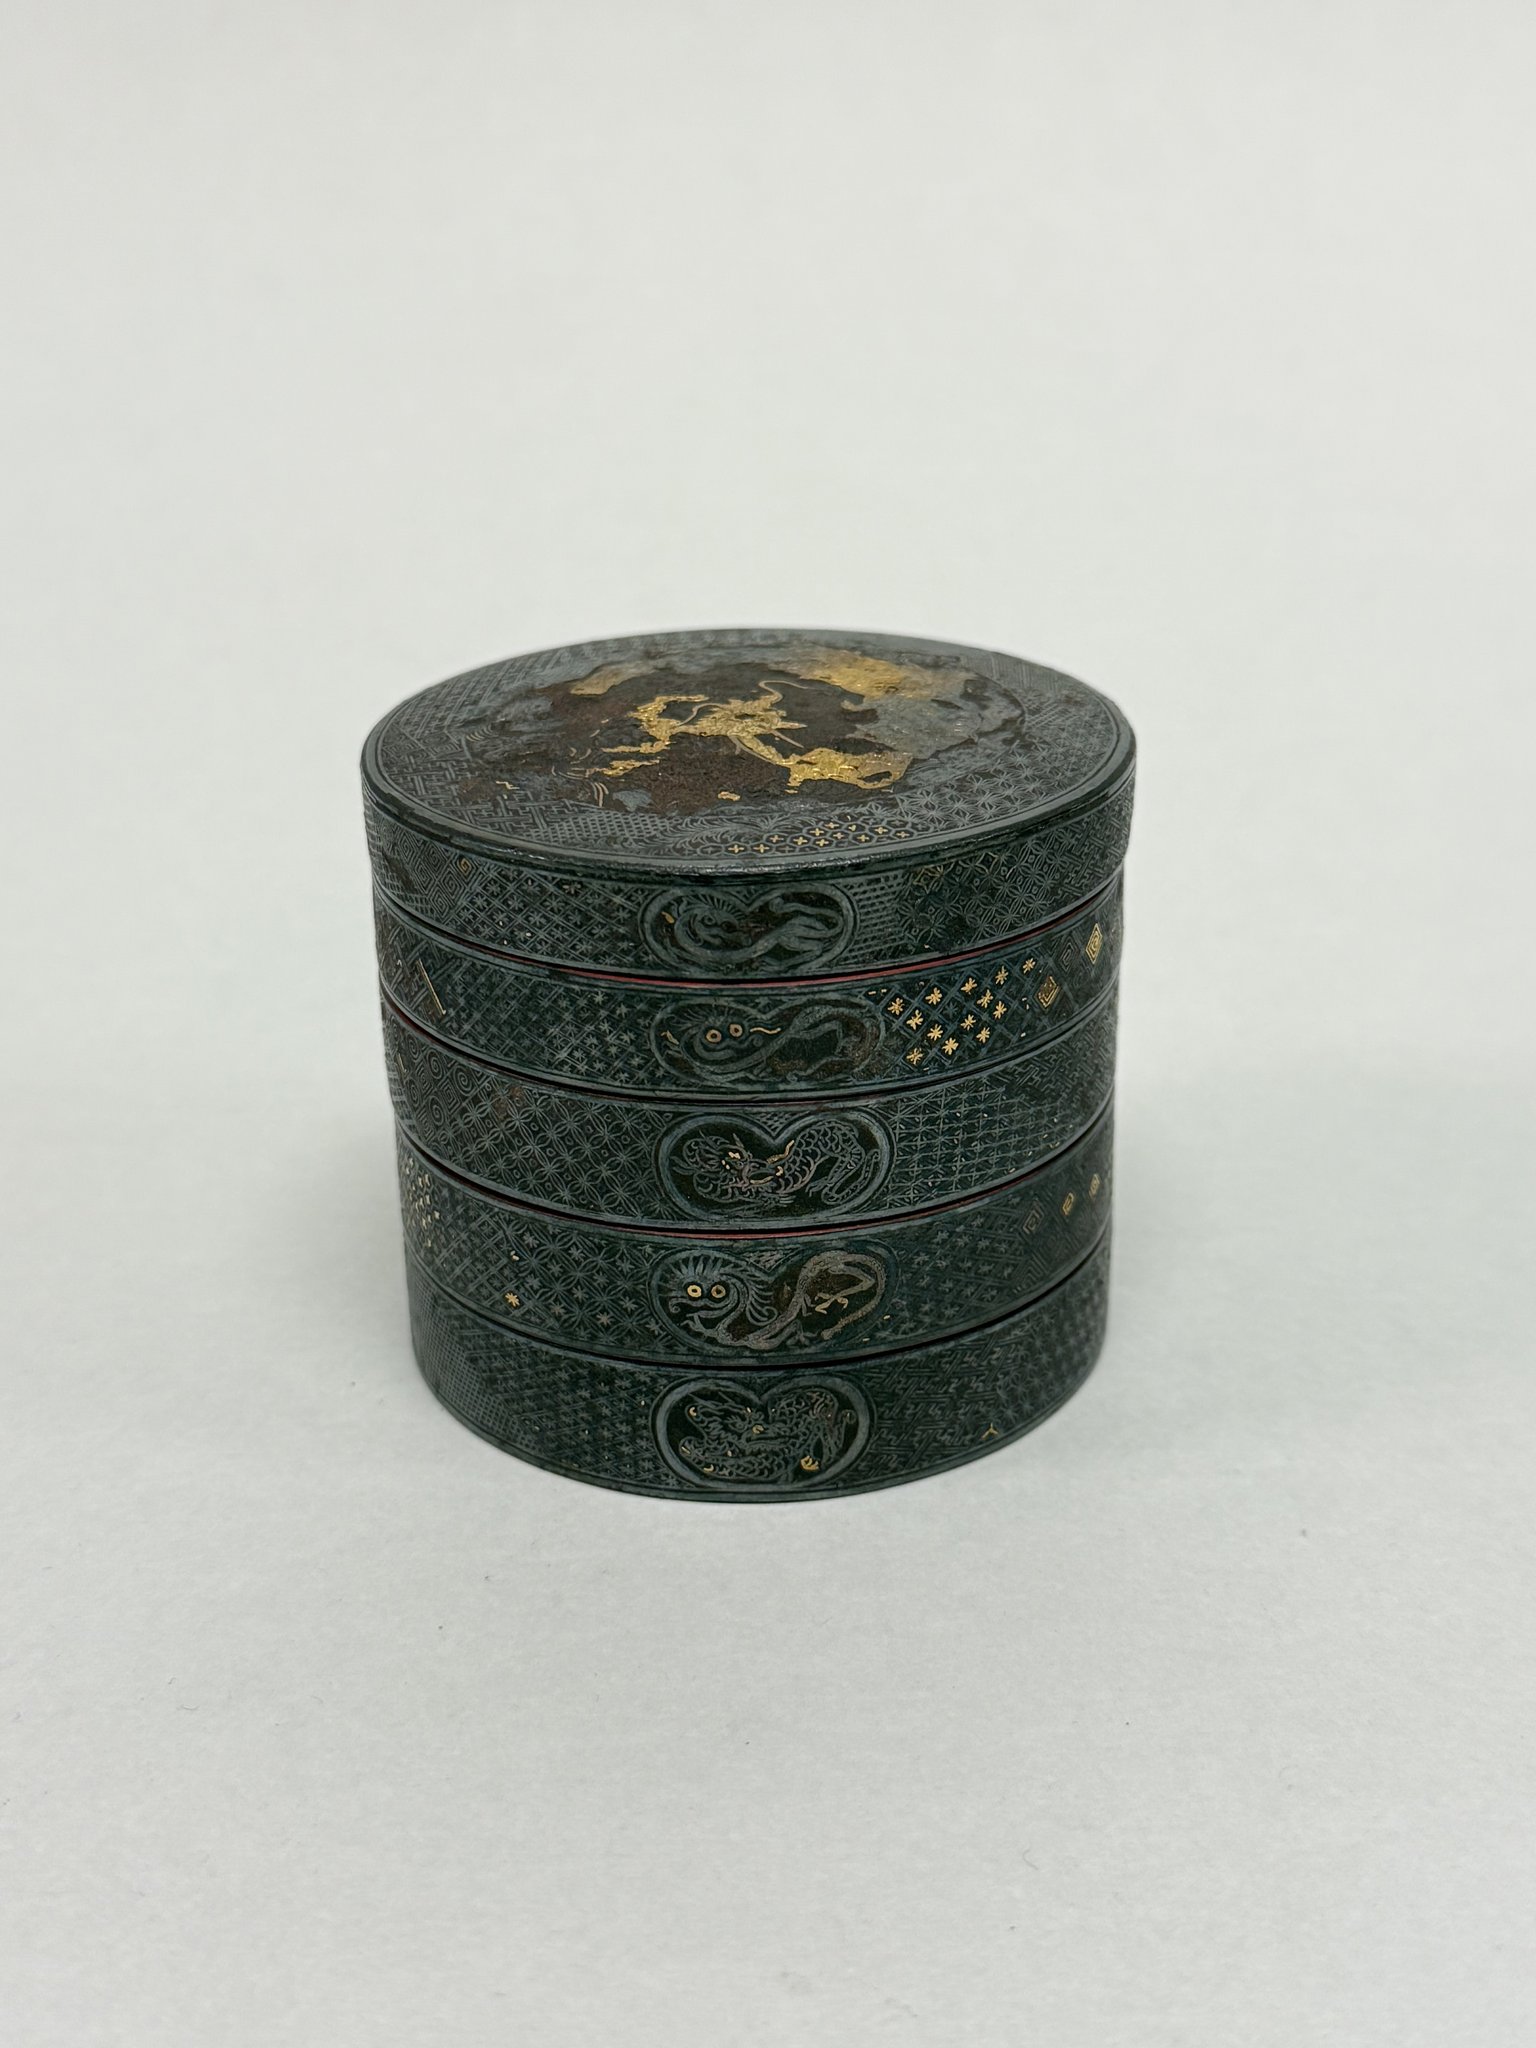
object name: incense box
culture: japanese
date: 1801-1900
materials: bronze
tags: dragons